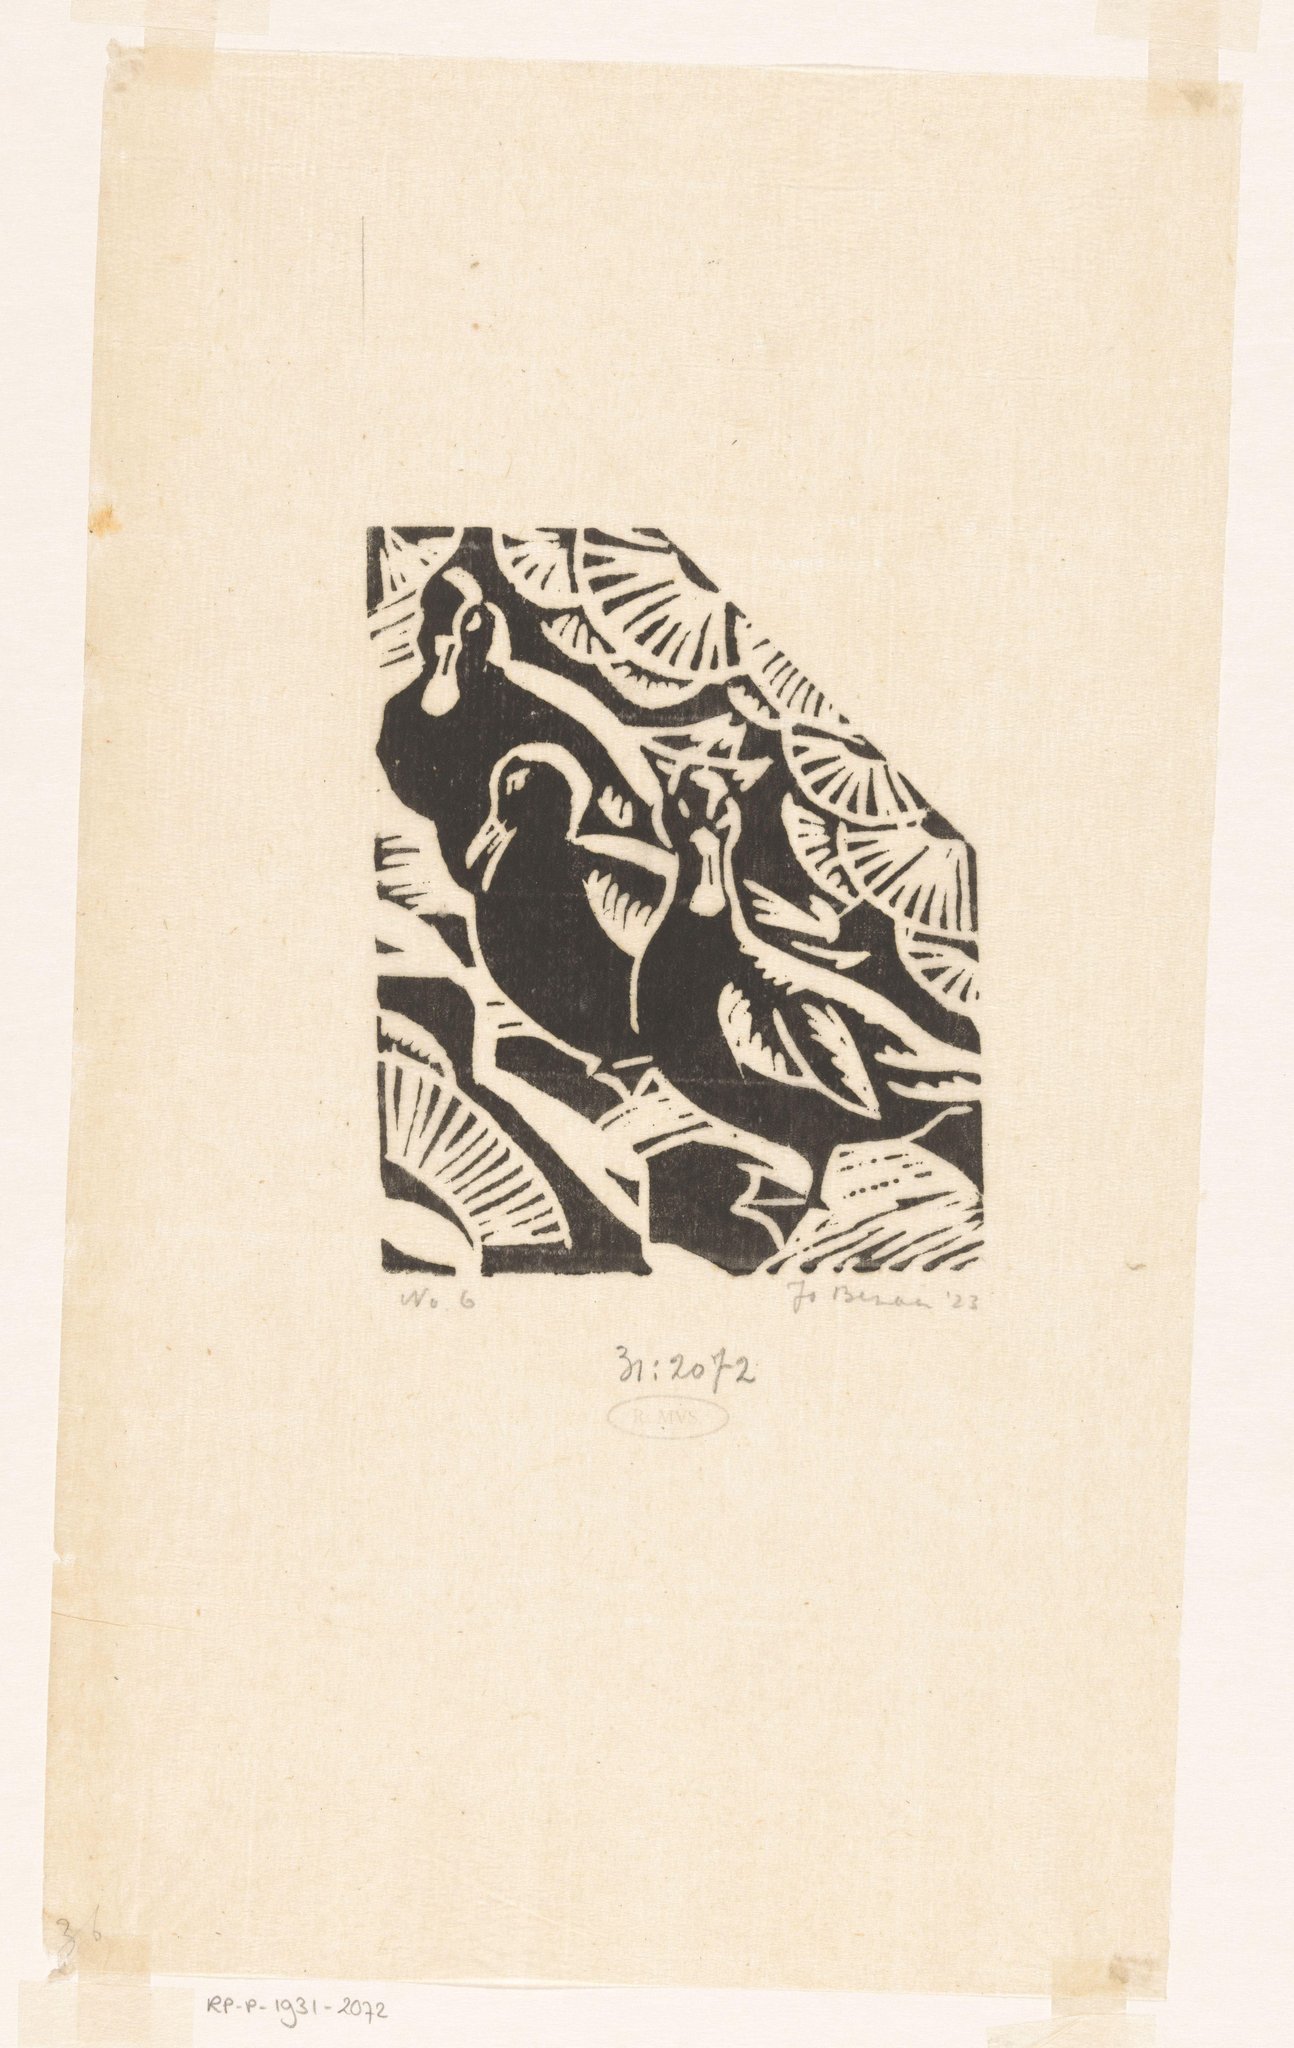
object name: print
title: Drie eenden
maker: jo bezaan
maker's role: draughtsman, print maker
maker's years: 1894-1952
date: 1923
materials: paper, ink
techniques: woodcut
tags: water-birds: duck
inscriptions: number: ‘Nr. 6’, collector's mark: Lugt 2228, signature and date: ‘Jo Bezaan ´23’